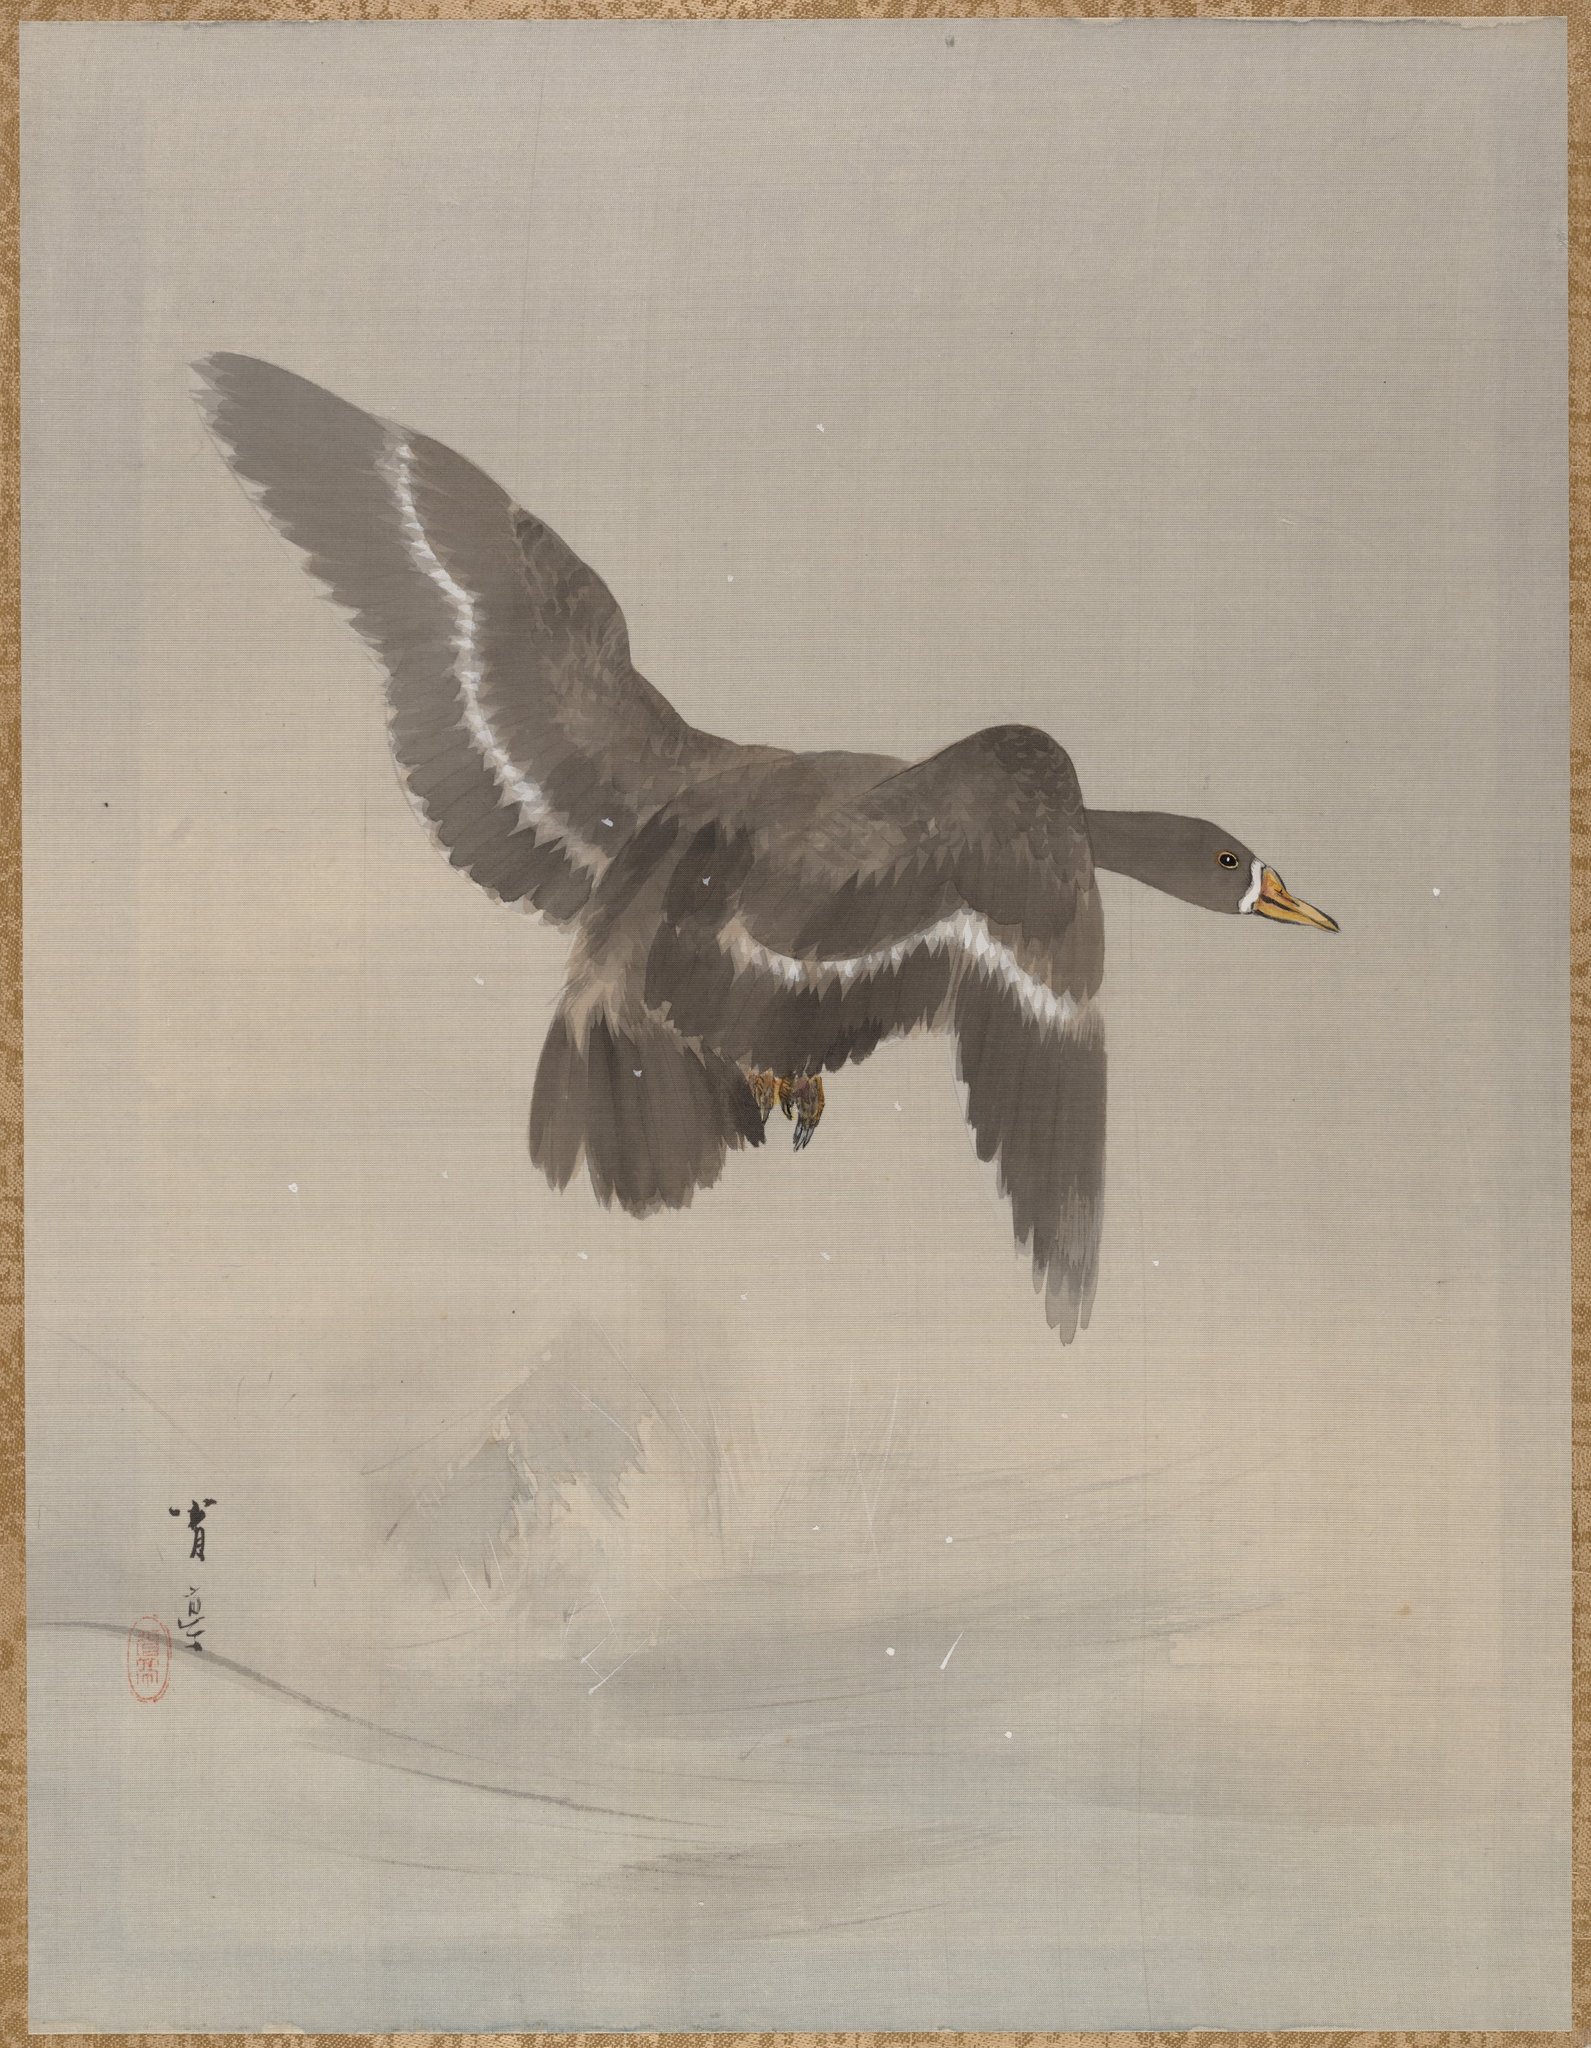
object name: album leaf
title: Flying Goose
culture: japanese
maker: watanabe seitei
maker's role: artist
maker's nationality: japanese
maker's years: 1851-1918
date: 1887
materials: ink, silk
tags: geese